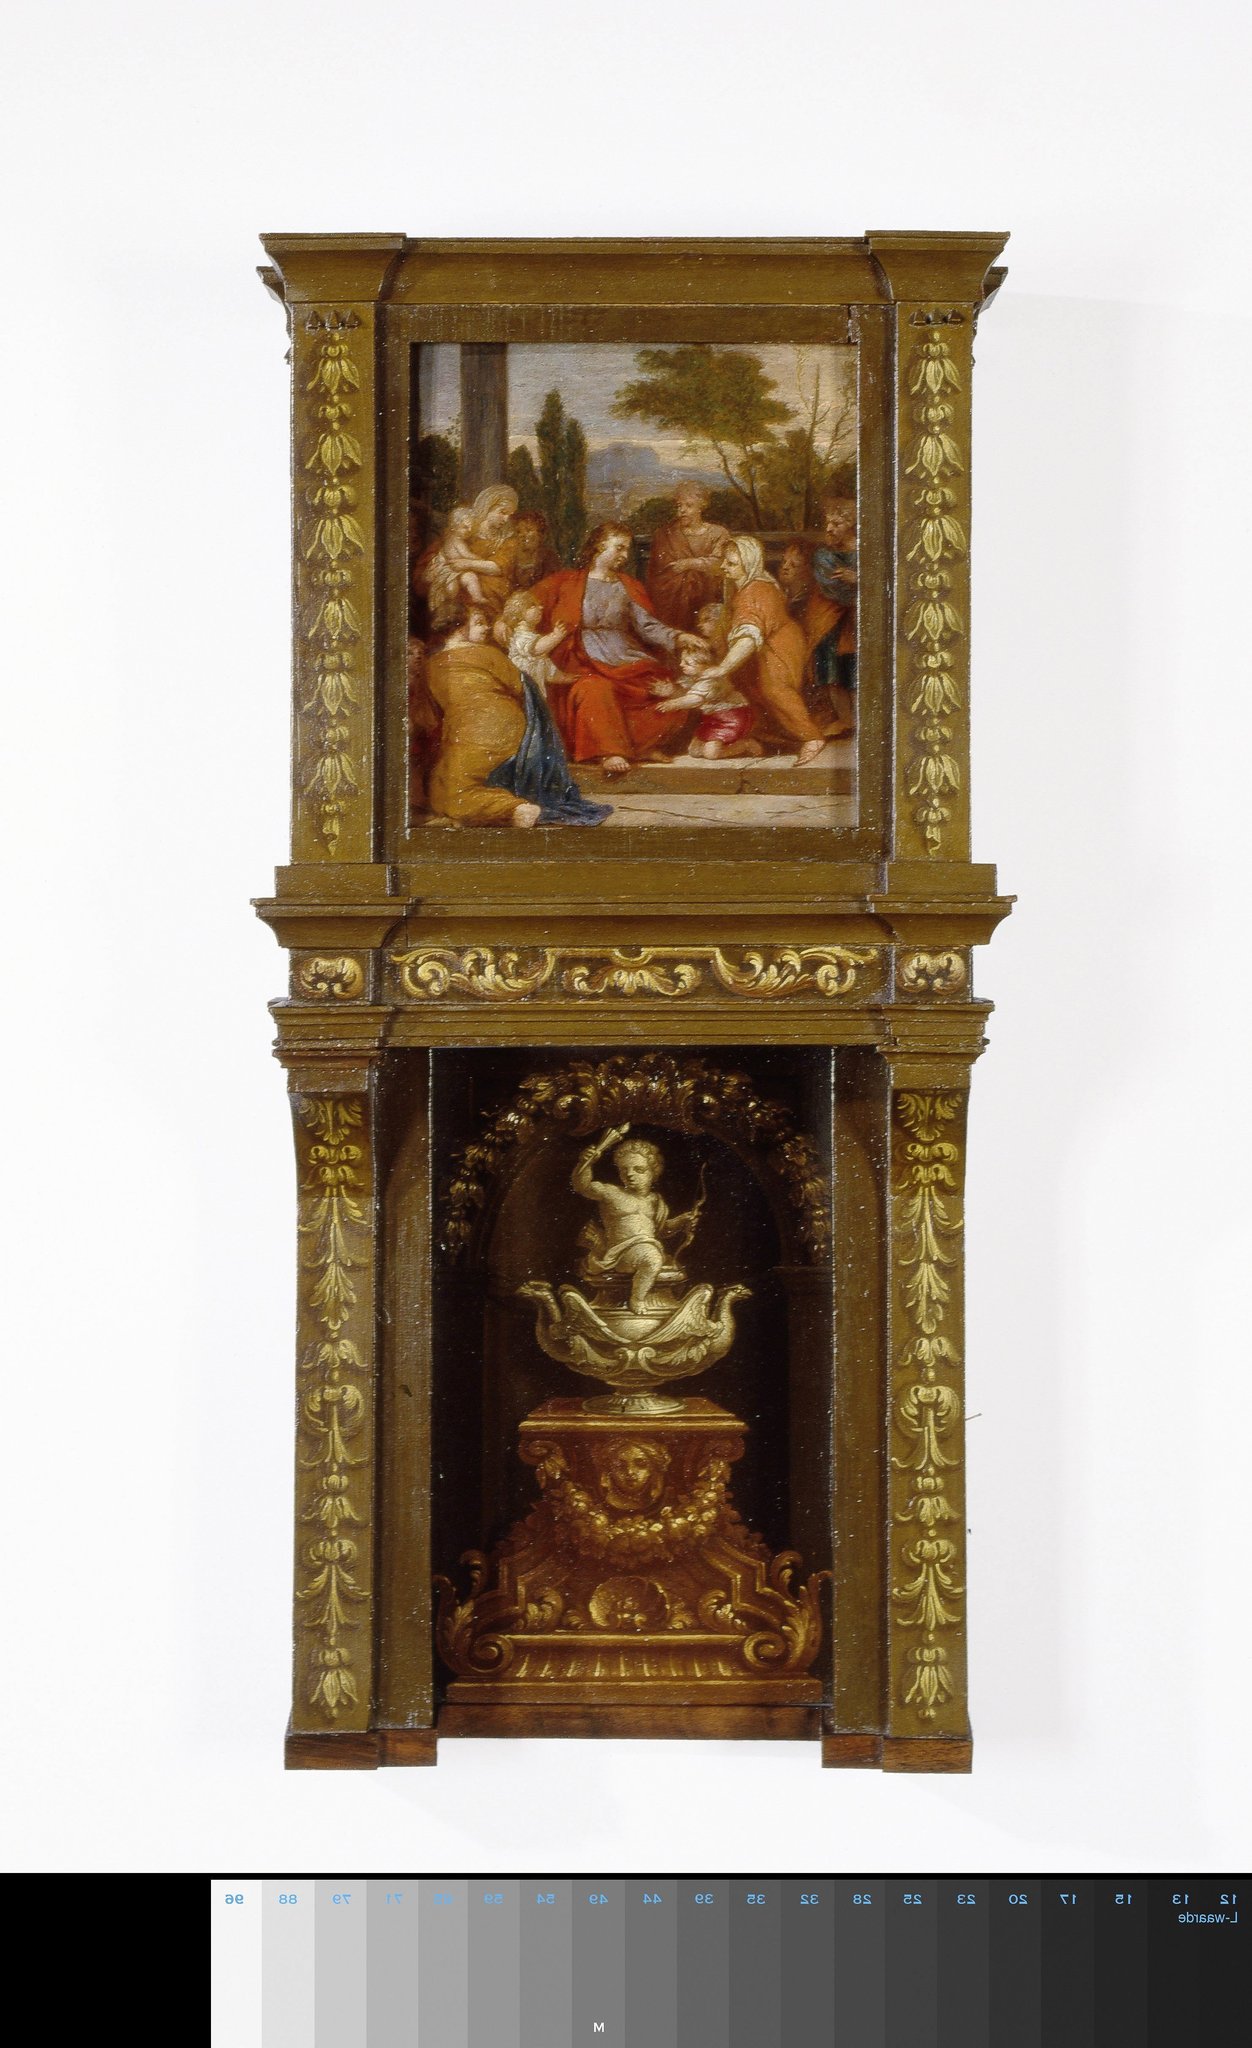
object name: painting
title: Toortsdragende Amor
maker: Anonymous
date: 1690-1710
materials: oil, panel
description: Schildering, aangebracht op de haard van een kamer, voorstellende een putto (Amor), gezeten op een vaas met 2 vogels als handvat, Amor steekt in zijn rechterhand een brandende toorts omhoog, en draagt links een boog. De vaas staat op een sokkel, versierd met een masker, vruchtenguirlande, bladvoluten en schelpmotief. De Amor en de sokkel zijn geschilderd in respectievelijk grijswitte en roodbruine grisaille-tinten. De achtergrond wordt gevormd door een halfronde nis afgesloten door een boog van bladkrans.